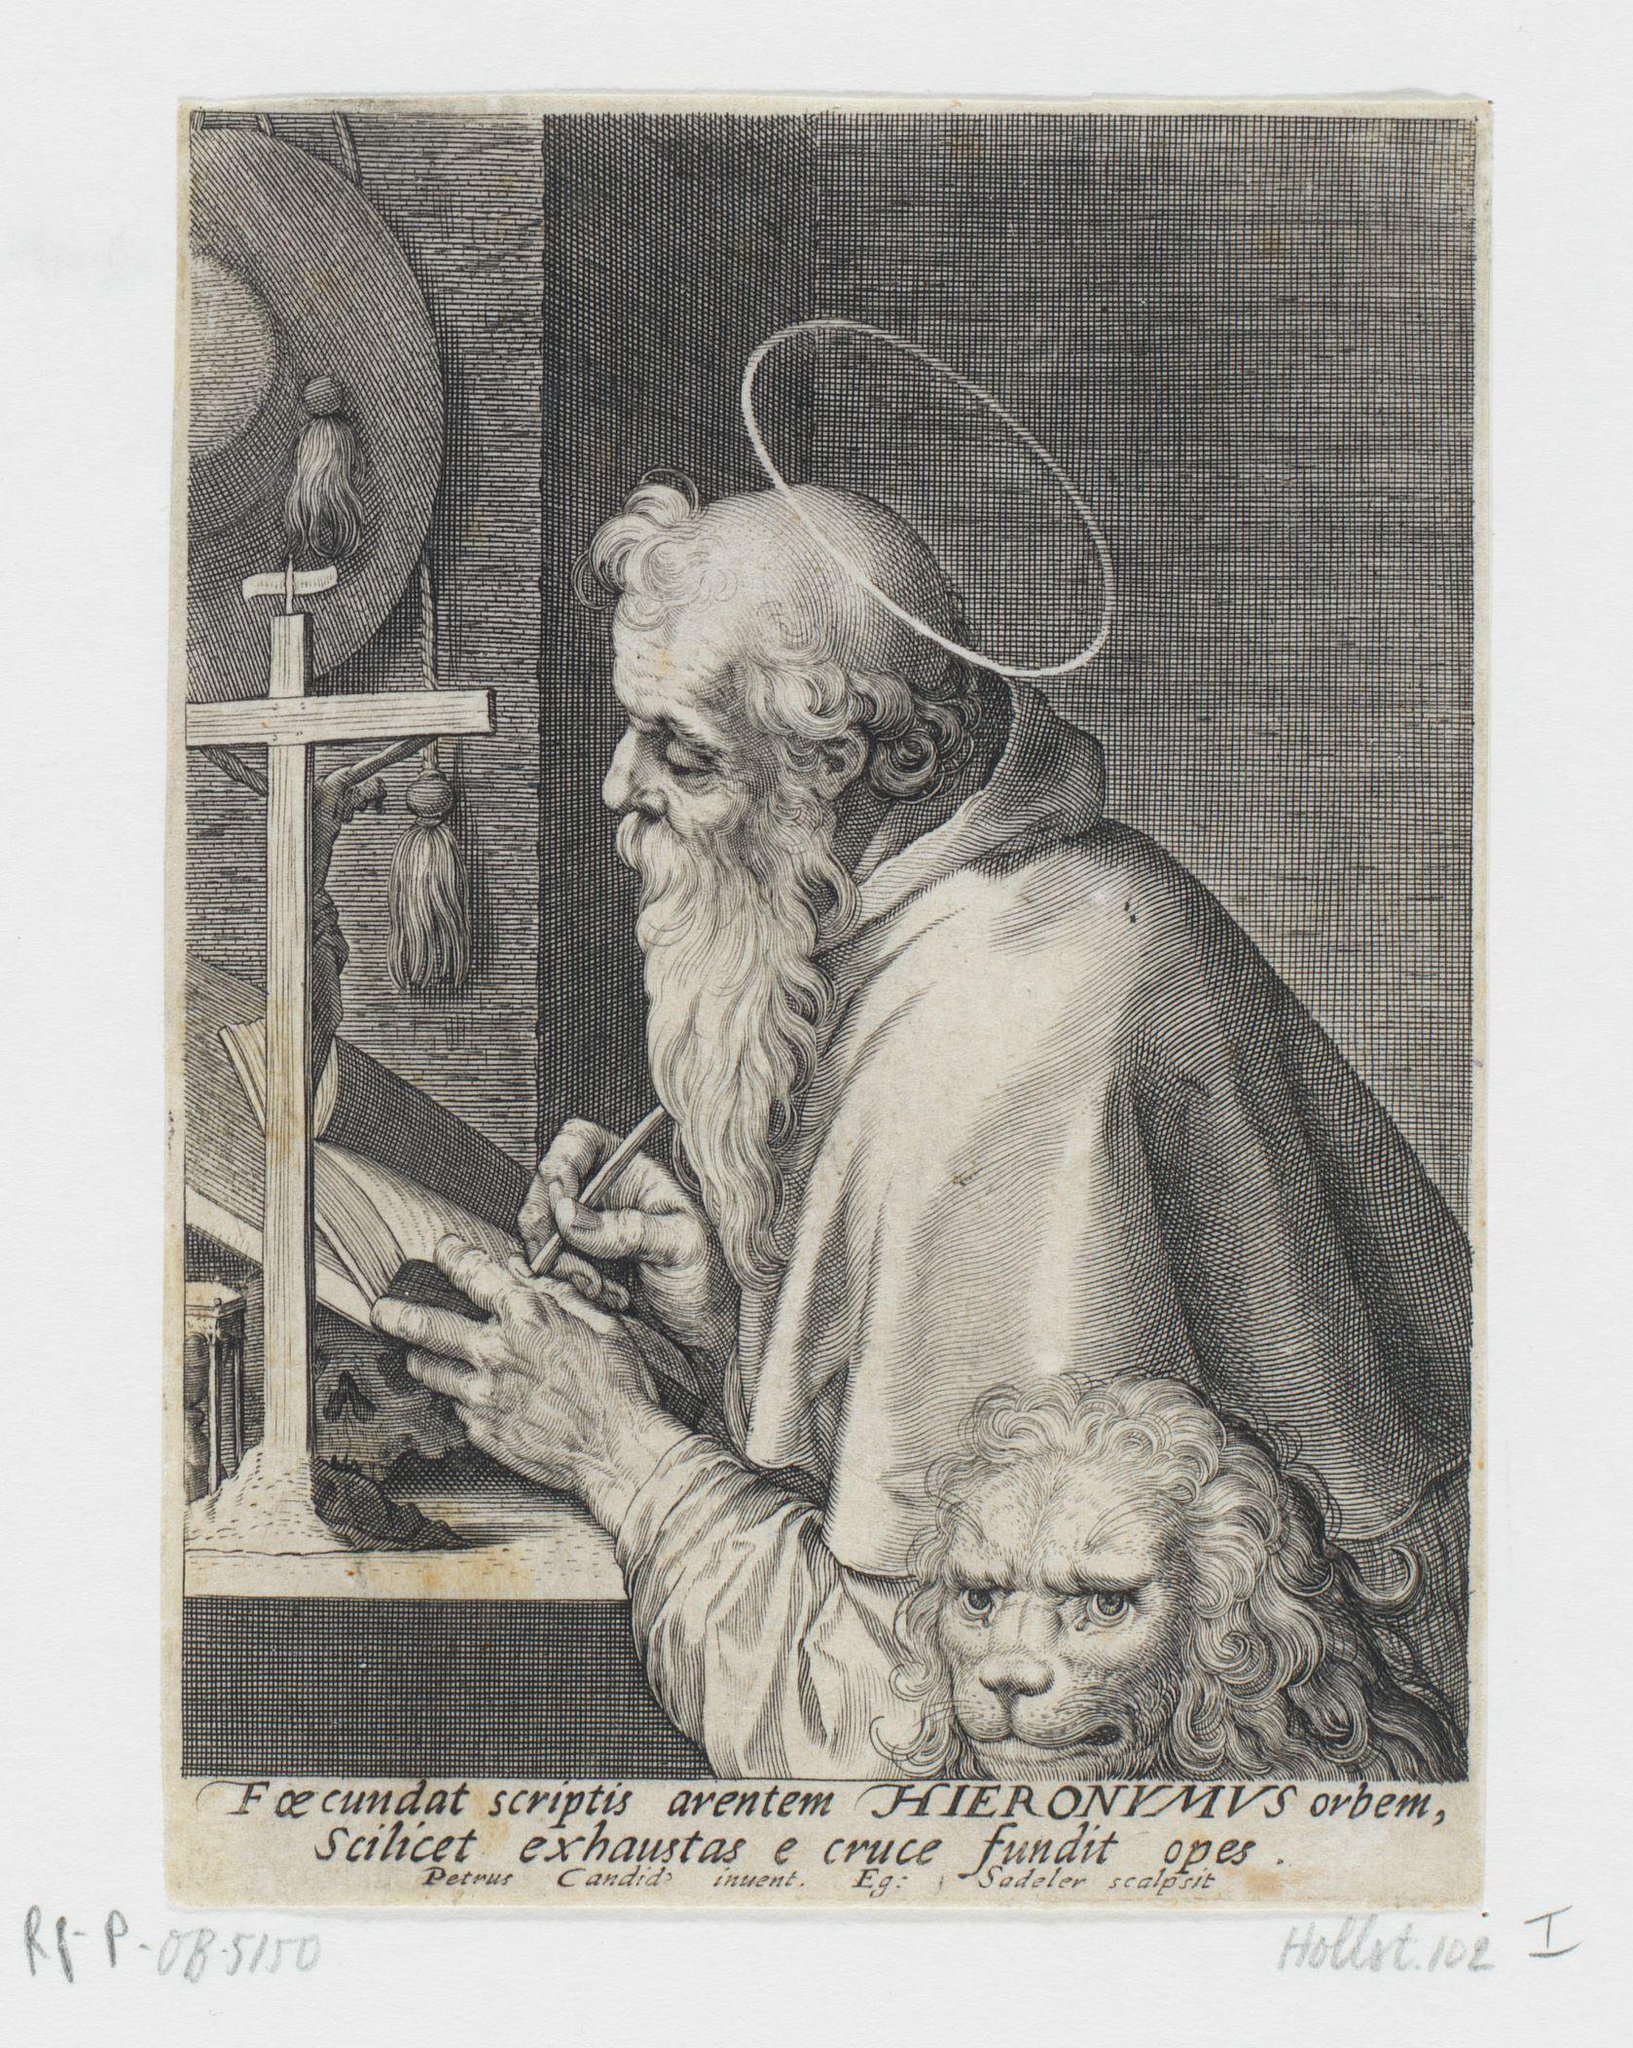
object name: print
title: Kerkvader Hieronymus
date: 1580-1629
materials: paper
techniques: engraving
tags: st. jerome as doctor of the latin church in his study with book, pen and ink; lion and cardinal's hat beside him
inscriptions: collector's mark: Lugt 240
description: De H. Hieronymus, schrijvend aan een tafel. De leeuw, zijn persoonlijk attribuut, zit naast hem. De prent heeft een Latijns onderschrift.